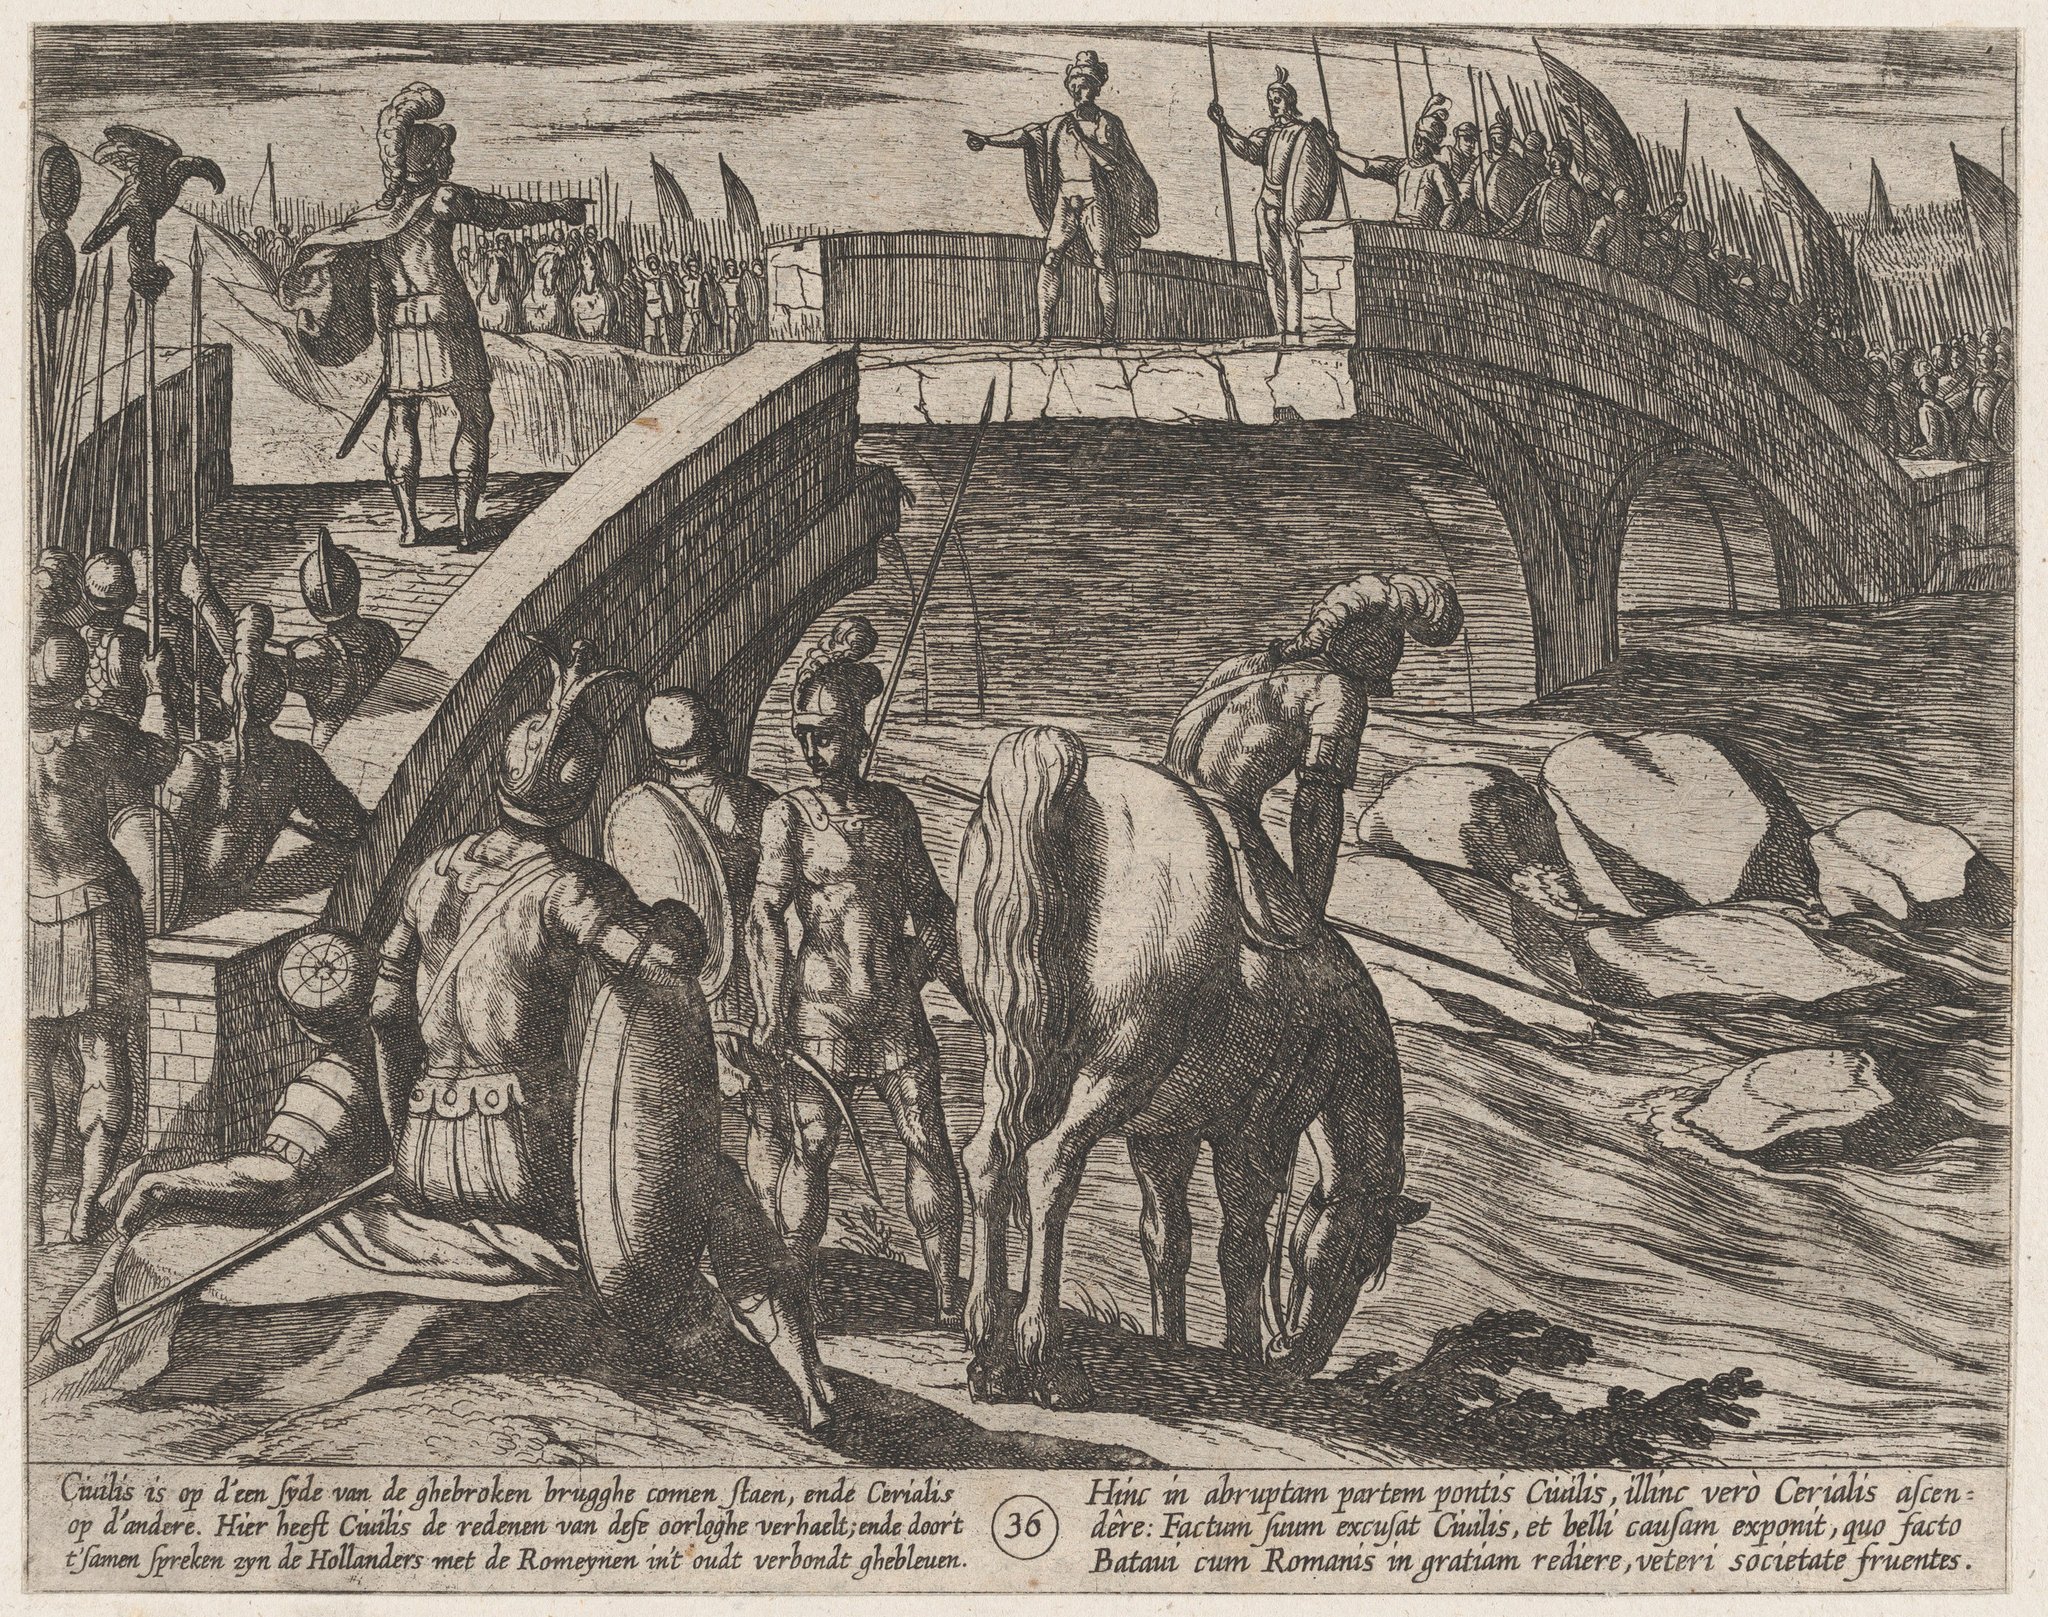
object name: print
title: Plate 36: Civilis and Cerialis Meet on a Broken Bridge to Reach an Accord, from The War of the Romans Against the Batavians (Romanorvm et Batavorvm societas)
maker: antonio tempesta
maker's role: artist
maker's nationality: italian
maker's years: 1555-1630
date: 1611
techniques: etching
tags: bridges,soldiers,horses